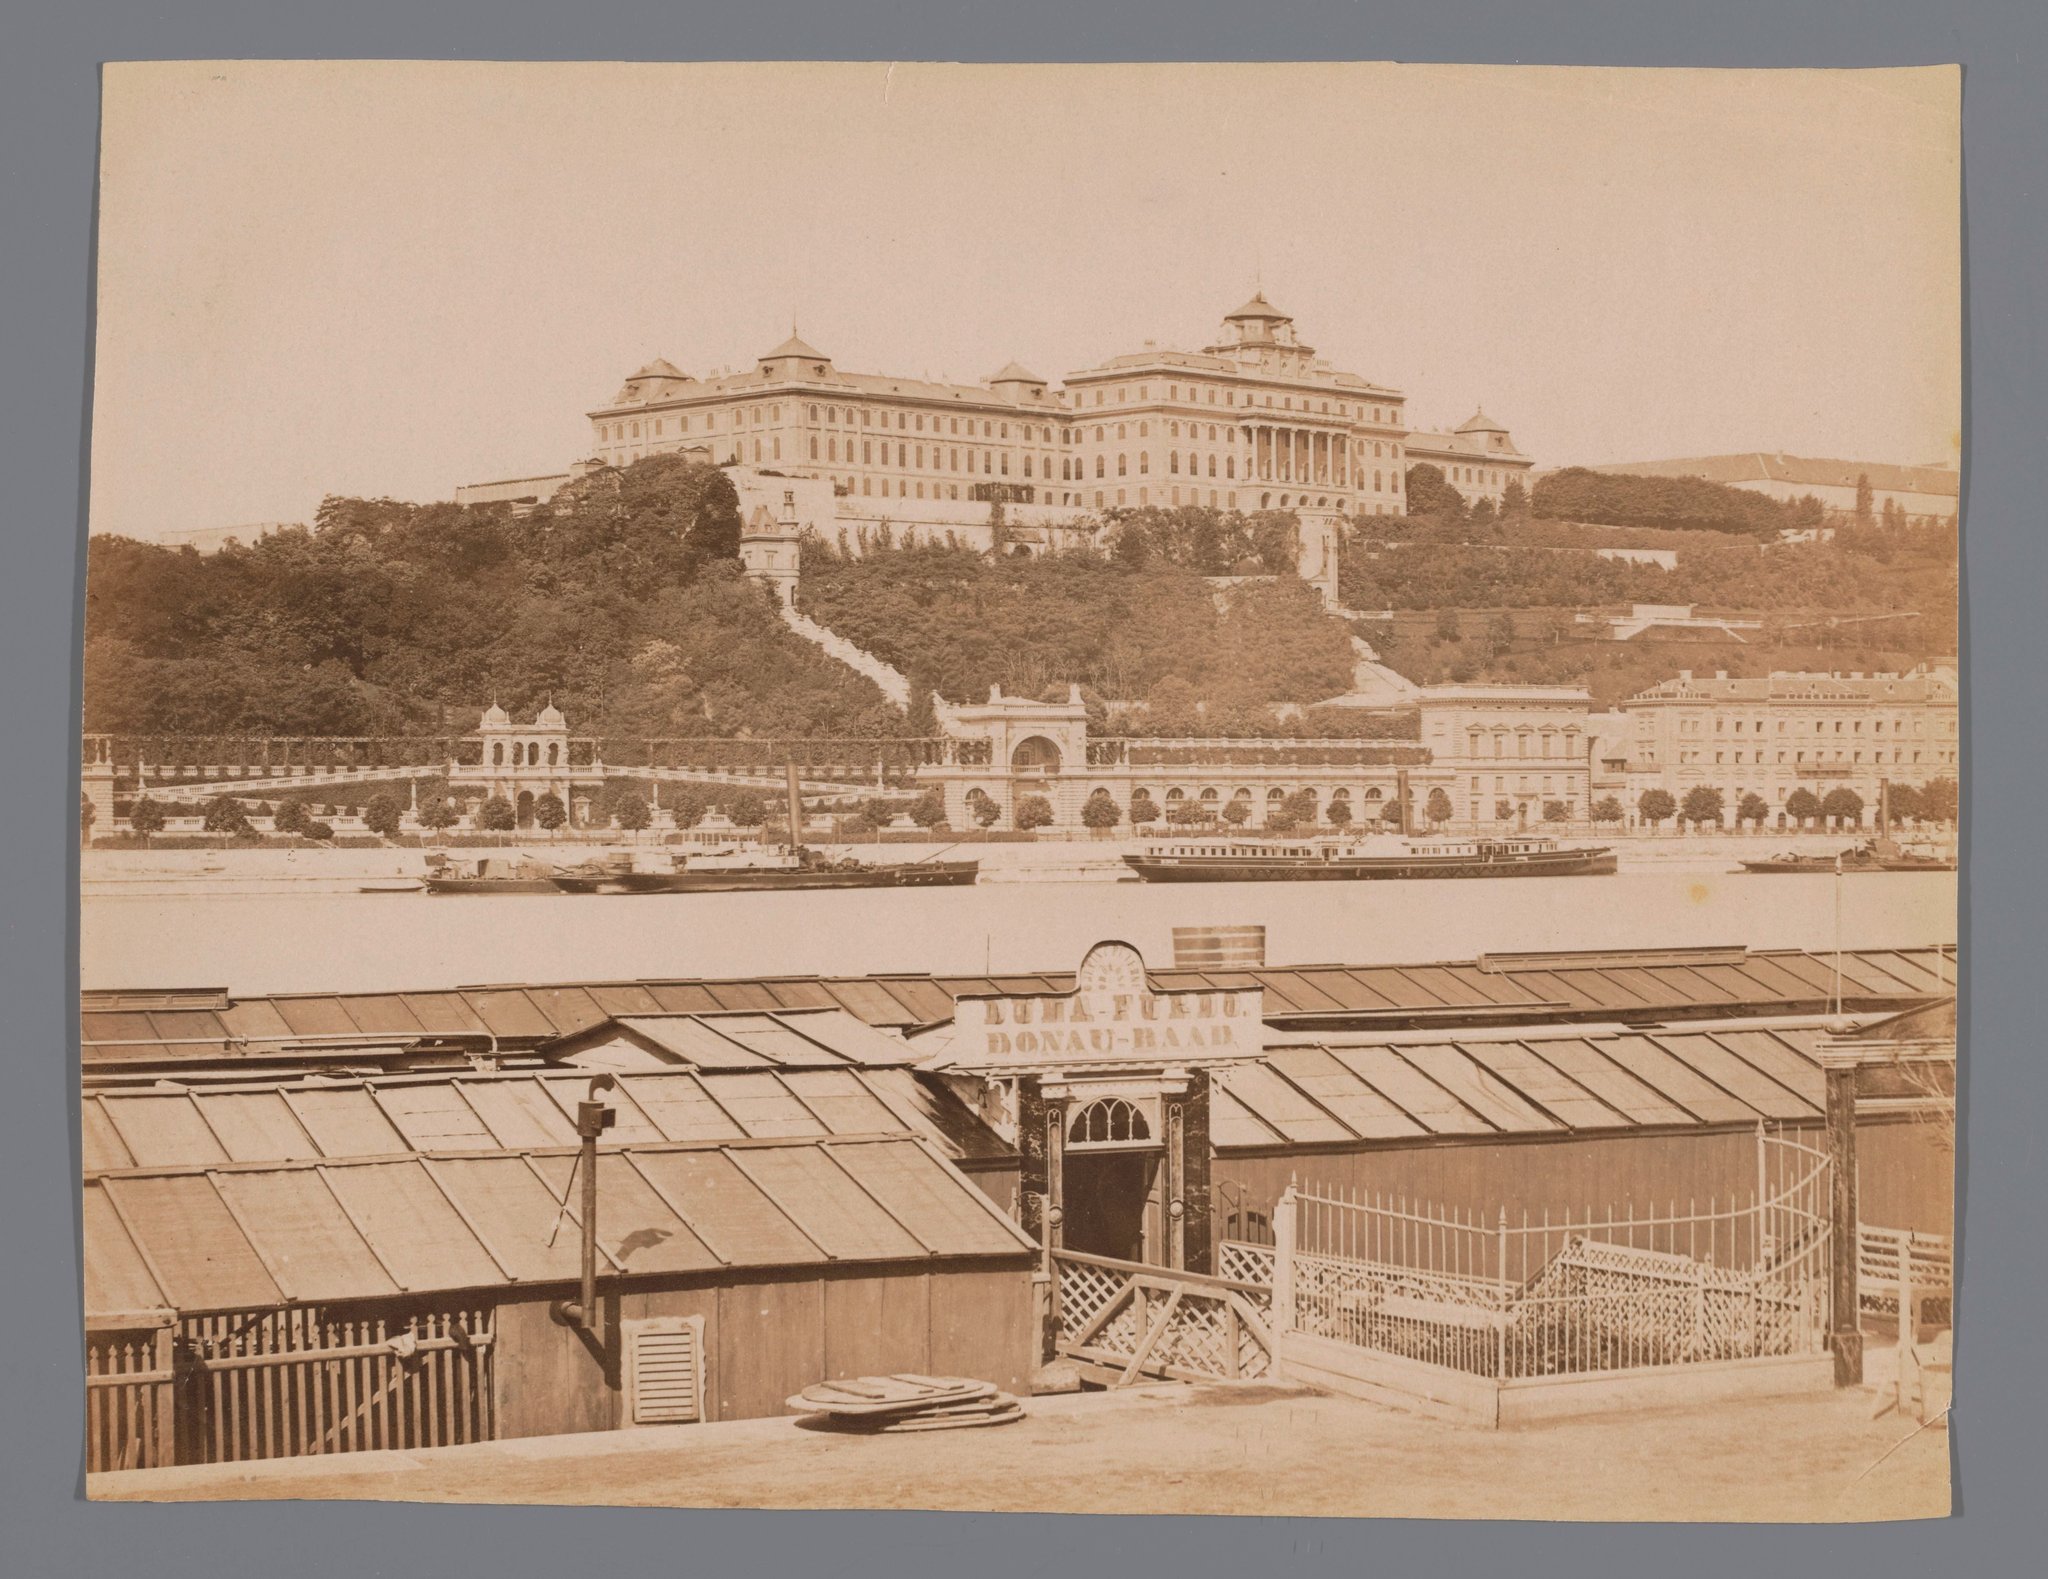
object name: photograph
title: Gezicht uit Pesth op de Kön Burg in Ofen (Buda)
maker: Anonymous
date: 1860-1900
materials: paper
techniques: albumen print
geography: budapest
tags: palace